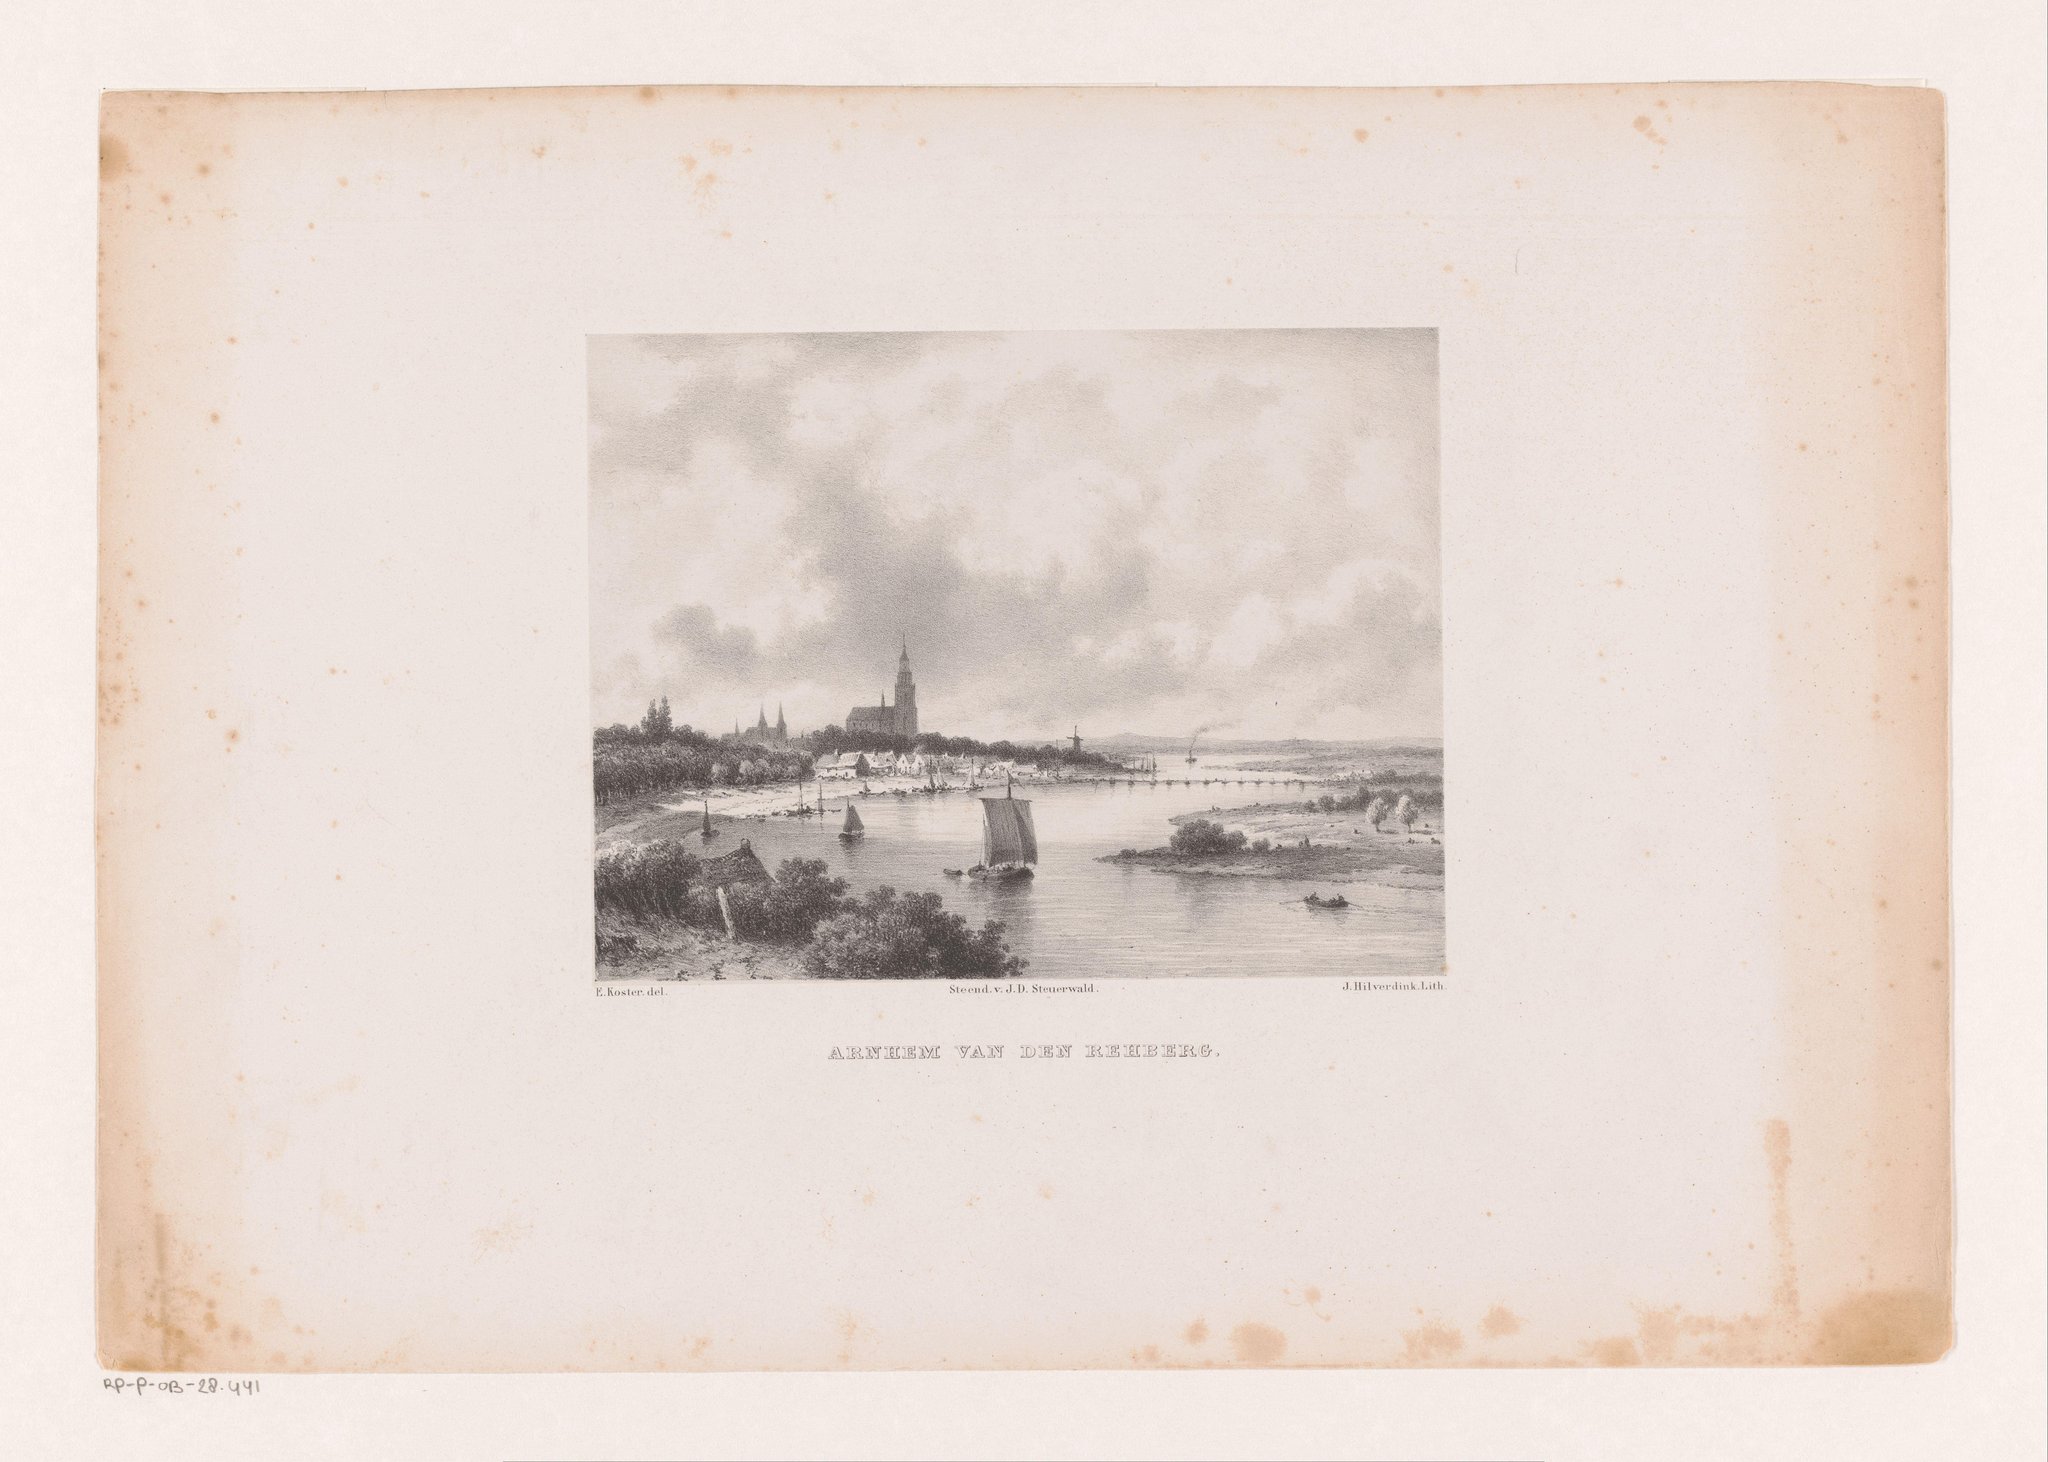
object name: print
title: Gezicht op Arnhem vanaf de Rehberg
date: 1858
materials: paper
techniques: lithograph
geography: amsterdam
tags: ships (in general), prospect of city, town panorama, silhouette of city, arnhem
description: Deze prent komt uit: Koster, E. 'E. Koster's schetsboek: Nederlandsche Stads- en Havengezichten, uitgegeven onder medewerking van de maatschappij Arti et Amicitiae, Amsterdam, F. Buffa en Zn., e.a.' Amsterdam 1858.